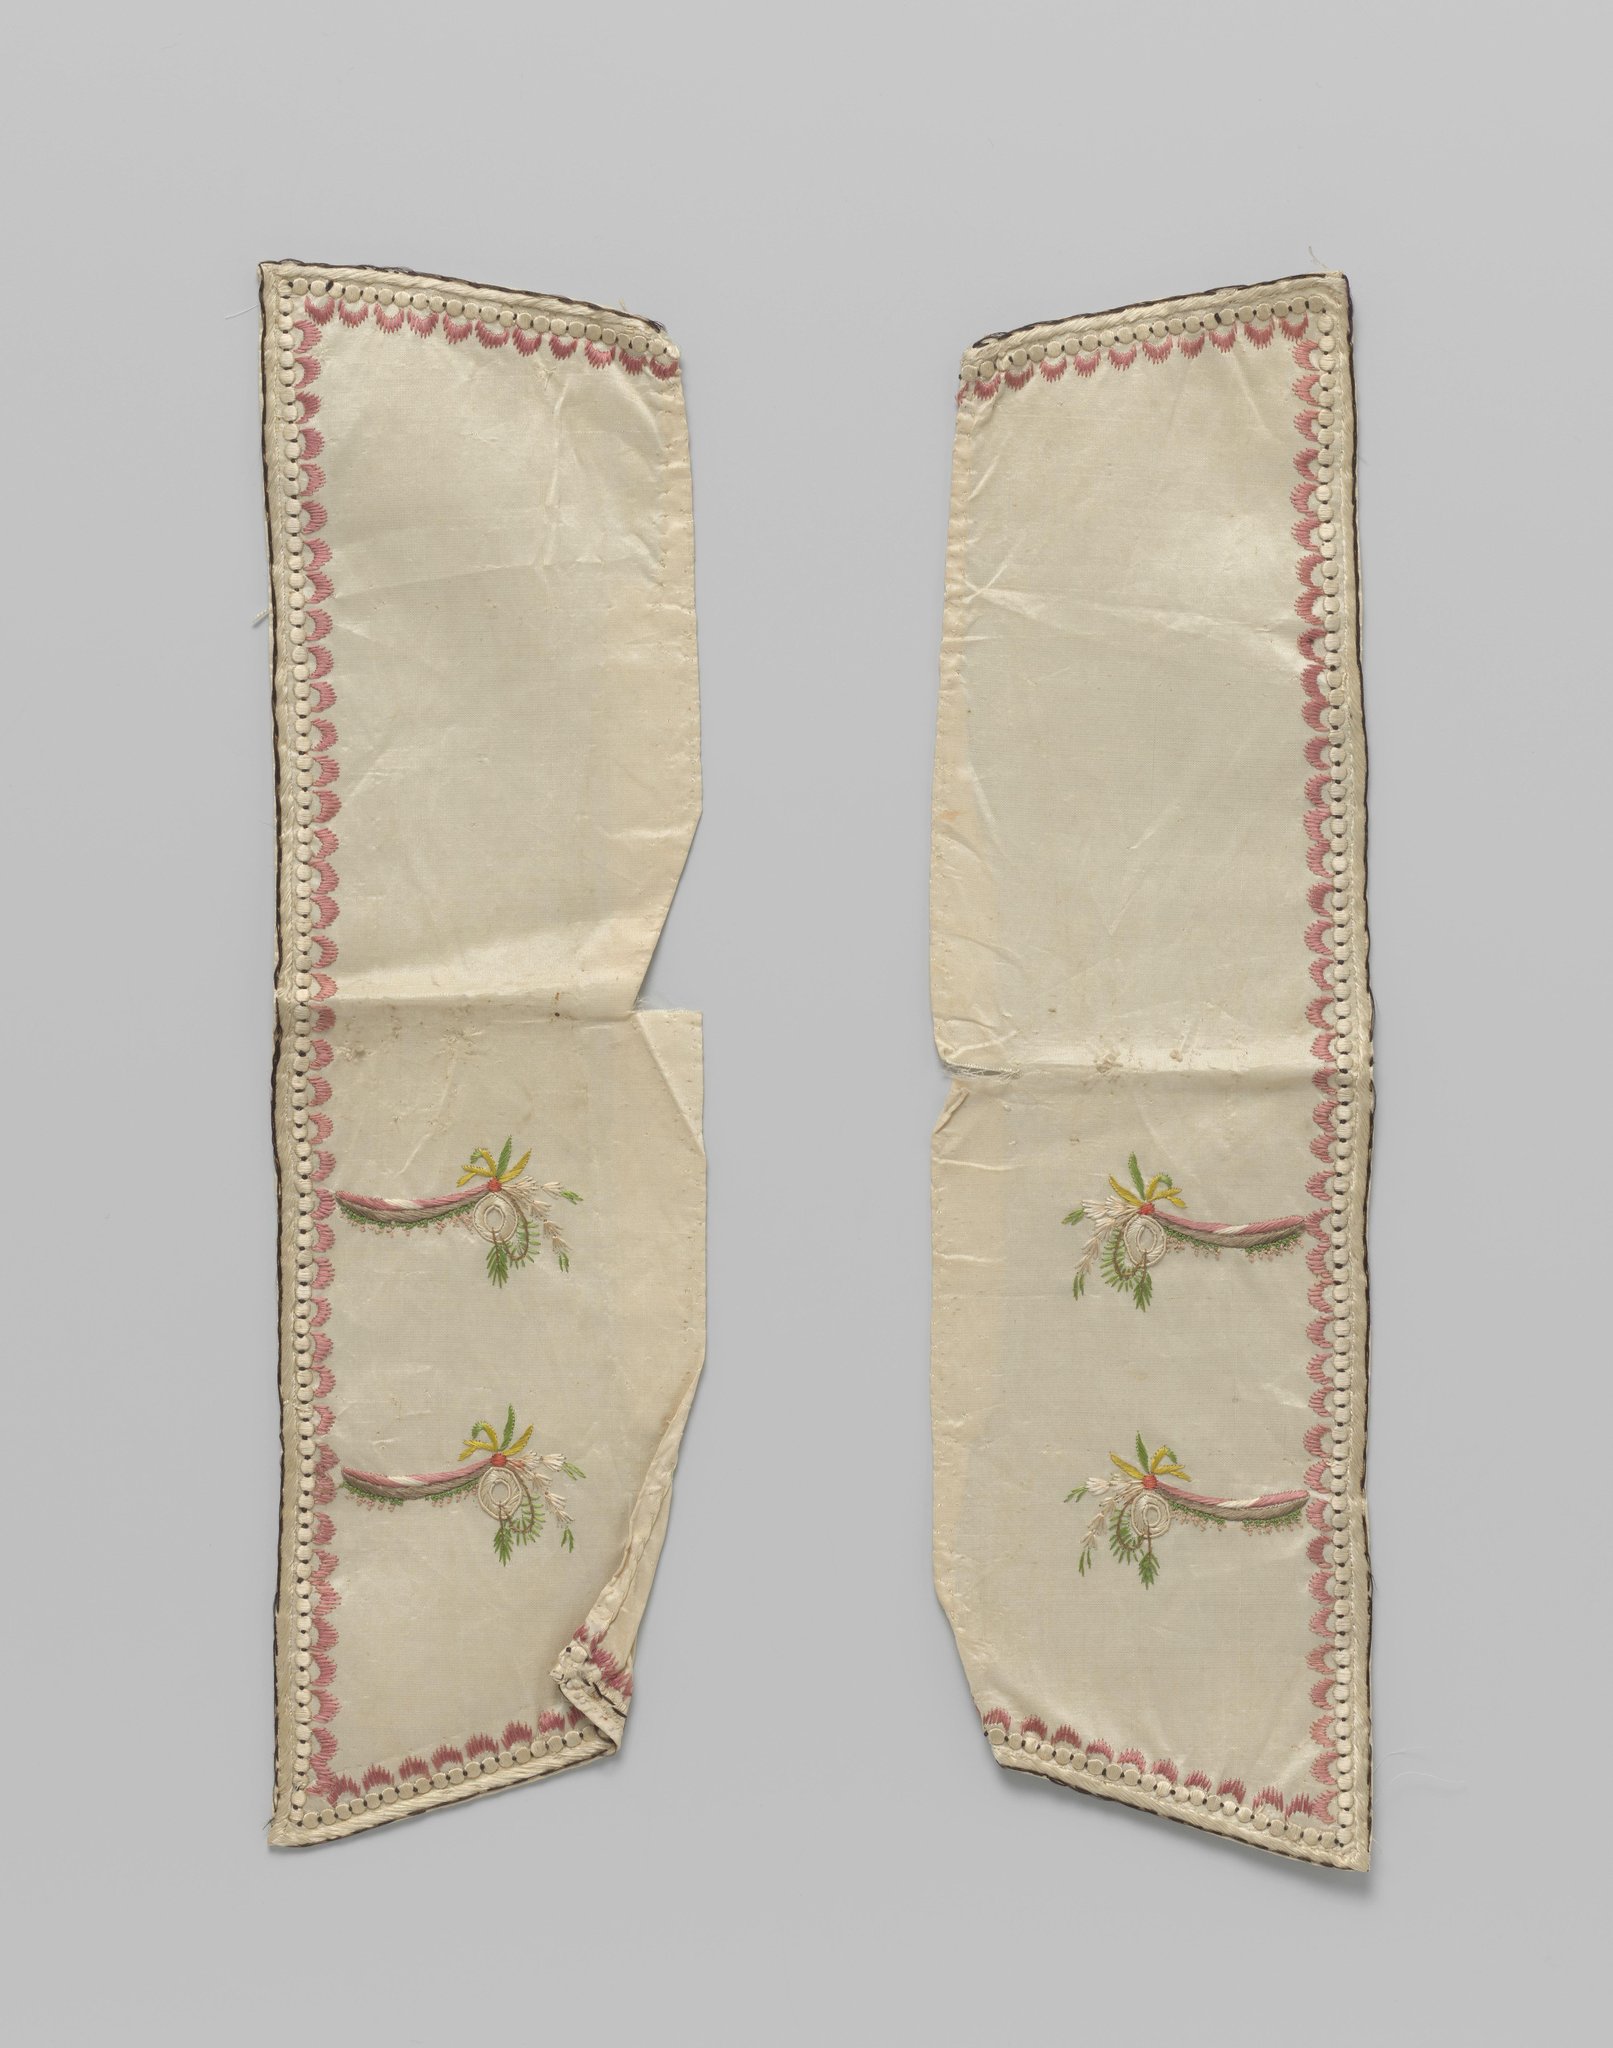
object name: cuff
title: Manchet met schijnknoopsgaten van witte ripszijde, met geborddurde parelrand en roze schulpen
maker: Anonymous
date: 1750-1800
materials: silk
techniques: embroidered, sewing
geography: netherlands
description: Manchet met schijnknoopsgaten van witte ripszijde, met geborddurde parelrand en roze schulpen.